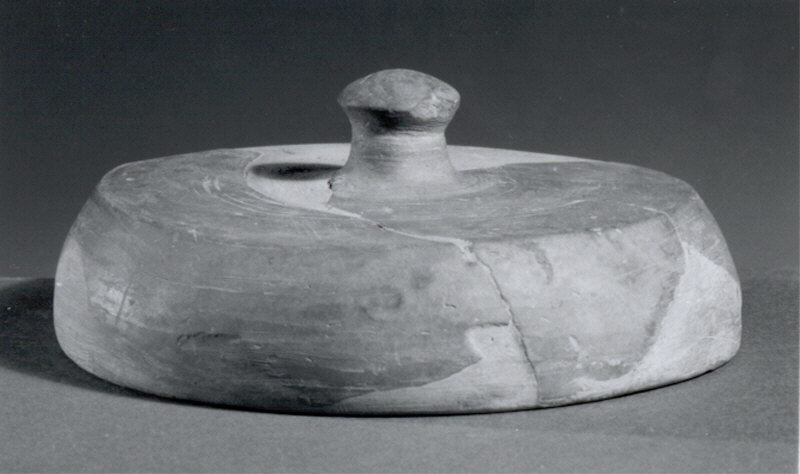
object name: lid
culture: iranian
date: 600-400 BCE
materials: ceramic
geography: iran